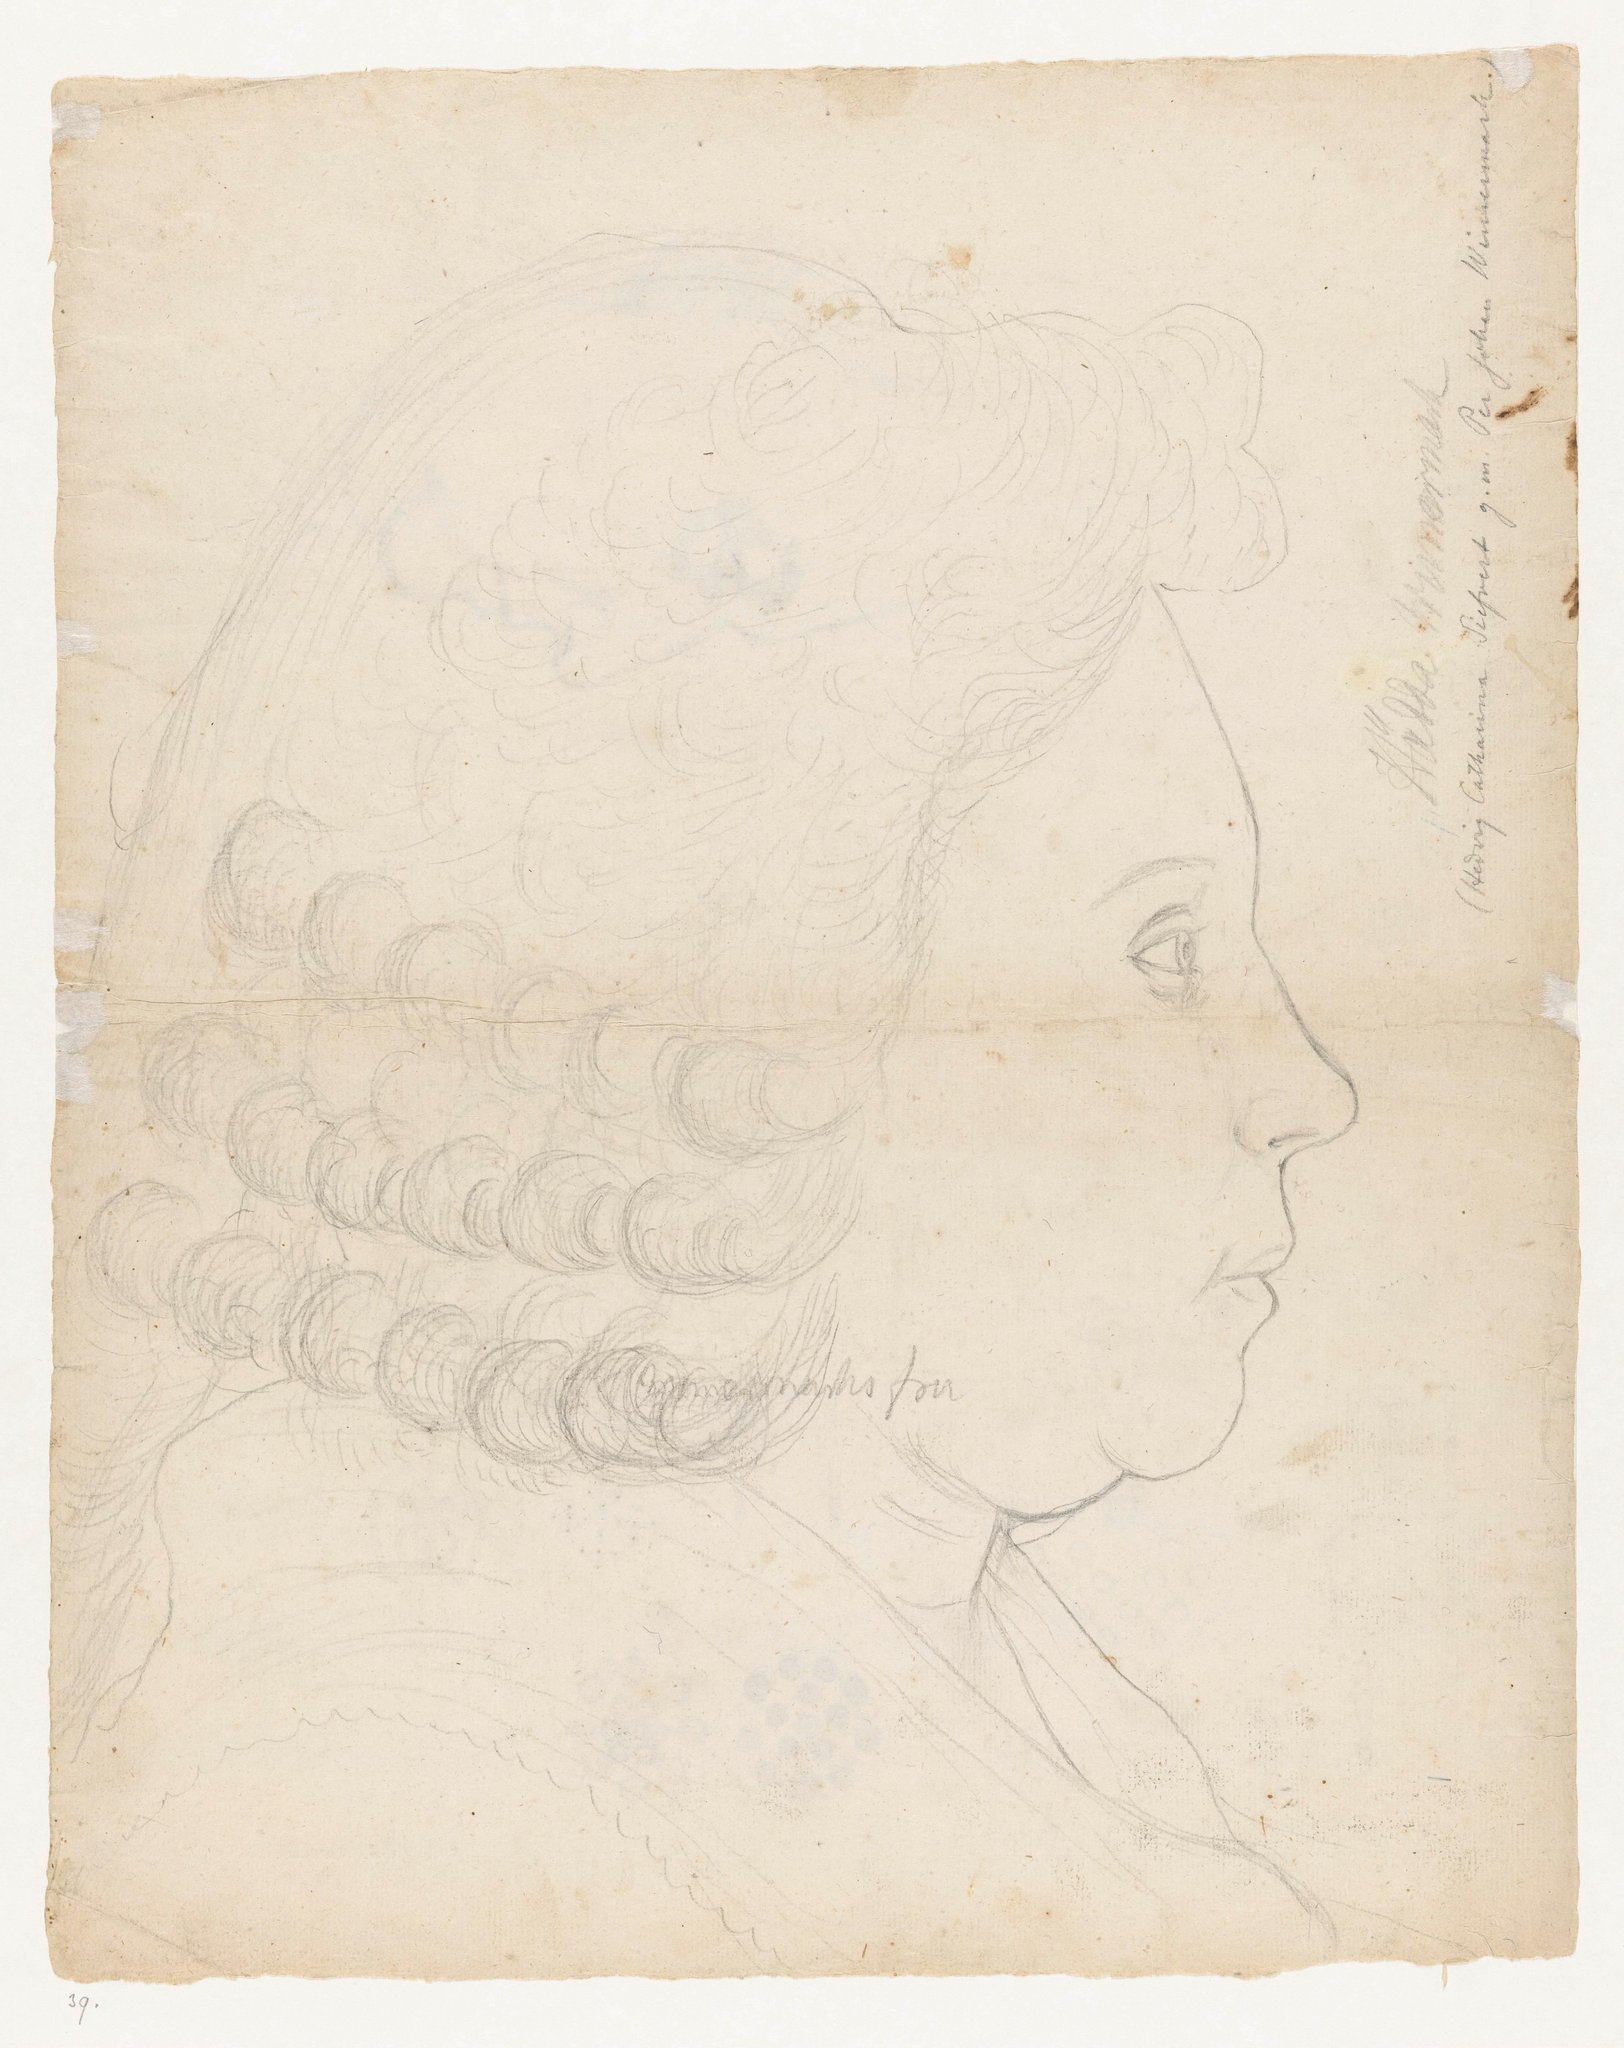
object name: drawing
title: Portret van Hedwig Catharina Wimermark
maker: jan brandes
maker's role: draughtsman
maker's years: 1743-1808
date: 1788-1806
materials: paper, pencil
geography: skälsebo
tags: historical persons - bb - woman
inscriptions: inscription: ‘Hädda Wimermark’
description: Portret van Hedwig ('Hädda') Catharina Wimermark, de vrouw van Per Johan Wimermark, in profiel naar rechts. Met opschriften. Verso schetsjes, van stoelen, gereedschap en een oefening van de sierletters die zijn gebruikt op een wapenbord, een zelfportret en profil en een silhouetlijn.